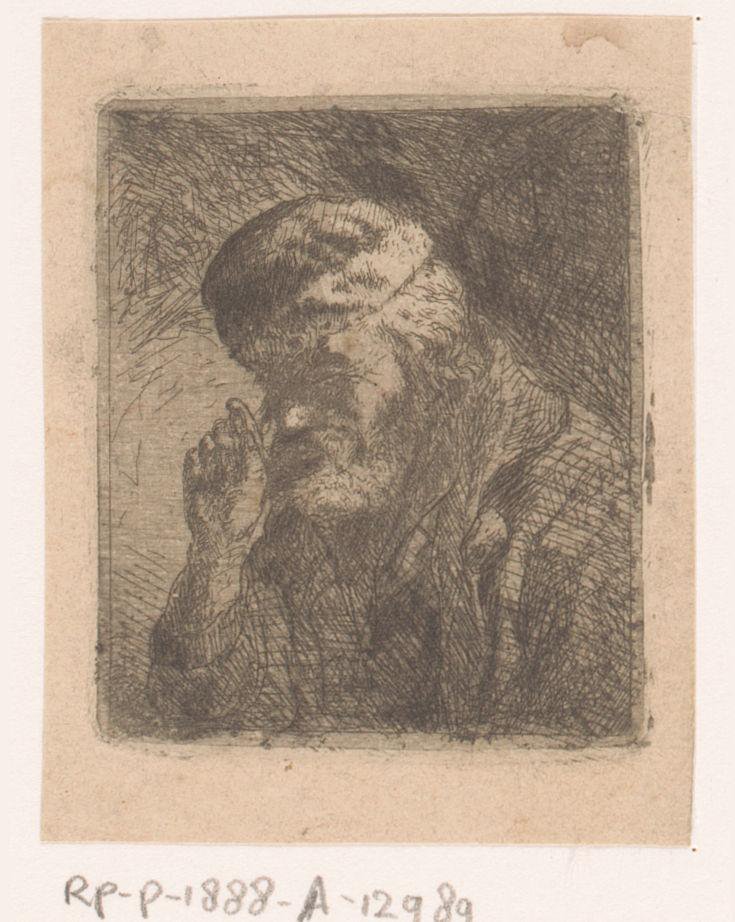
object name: print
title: Oude man met hand bij zijn neus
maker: florent nicolas crabeels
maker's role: print maker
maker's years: 1829-1896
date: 1839-1879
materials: paper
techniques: drypoint, etching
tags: old man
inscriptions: collector's mark: Lugt 2228